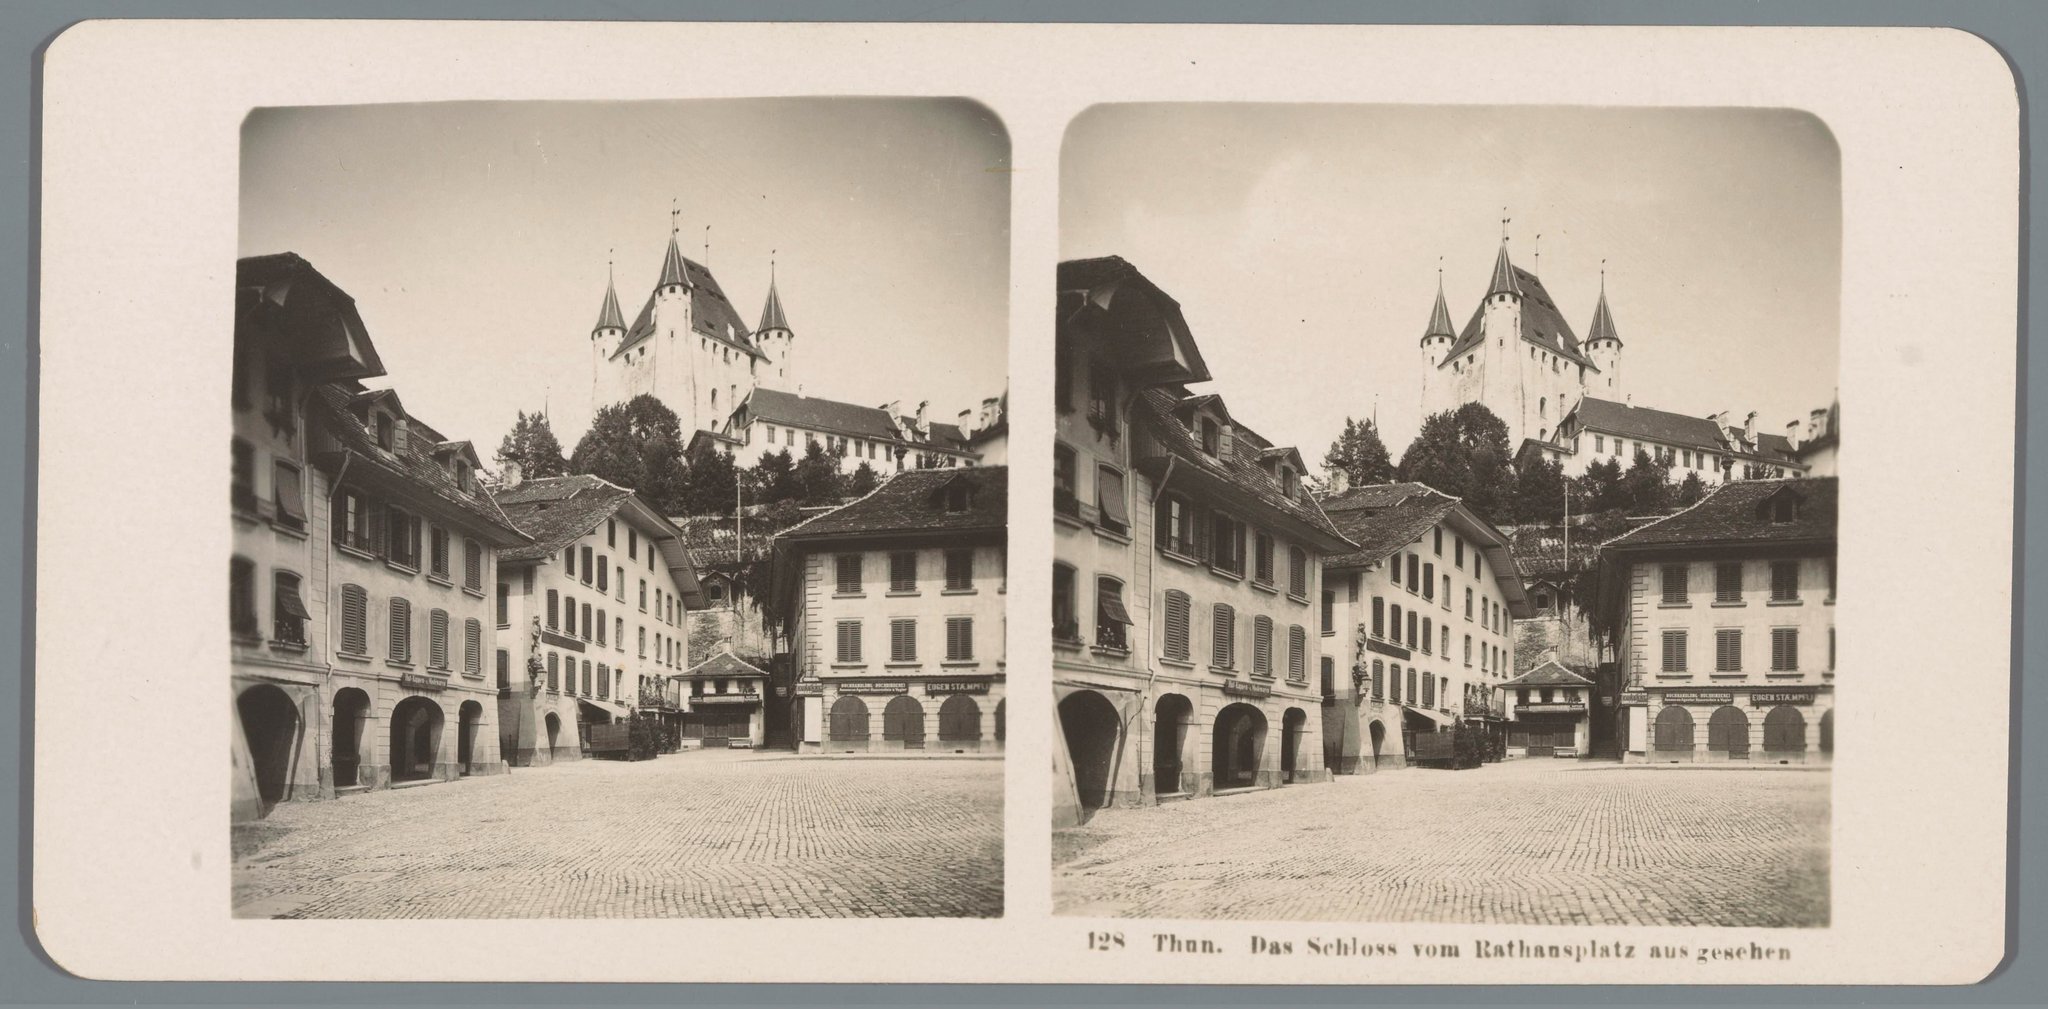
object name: stereograph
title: Thun. Das schloss vom Rathausplatz aus gesehen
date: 1906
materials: cardboard, photographic support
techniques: gelatin silver print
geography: thun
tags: castle, façade (of house or building), village square, place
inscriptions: inscription: ‘Neue Photographische Gesellschaft A. G., Steglitz-Berlin 1906.’, number: ‘128’